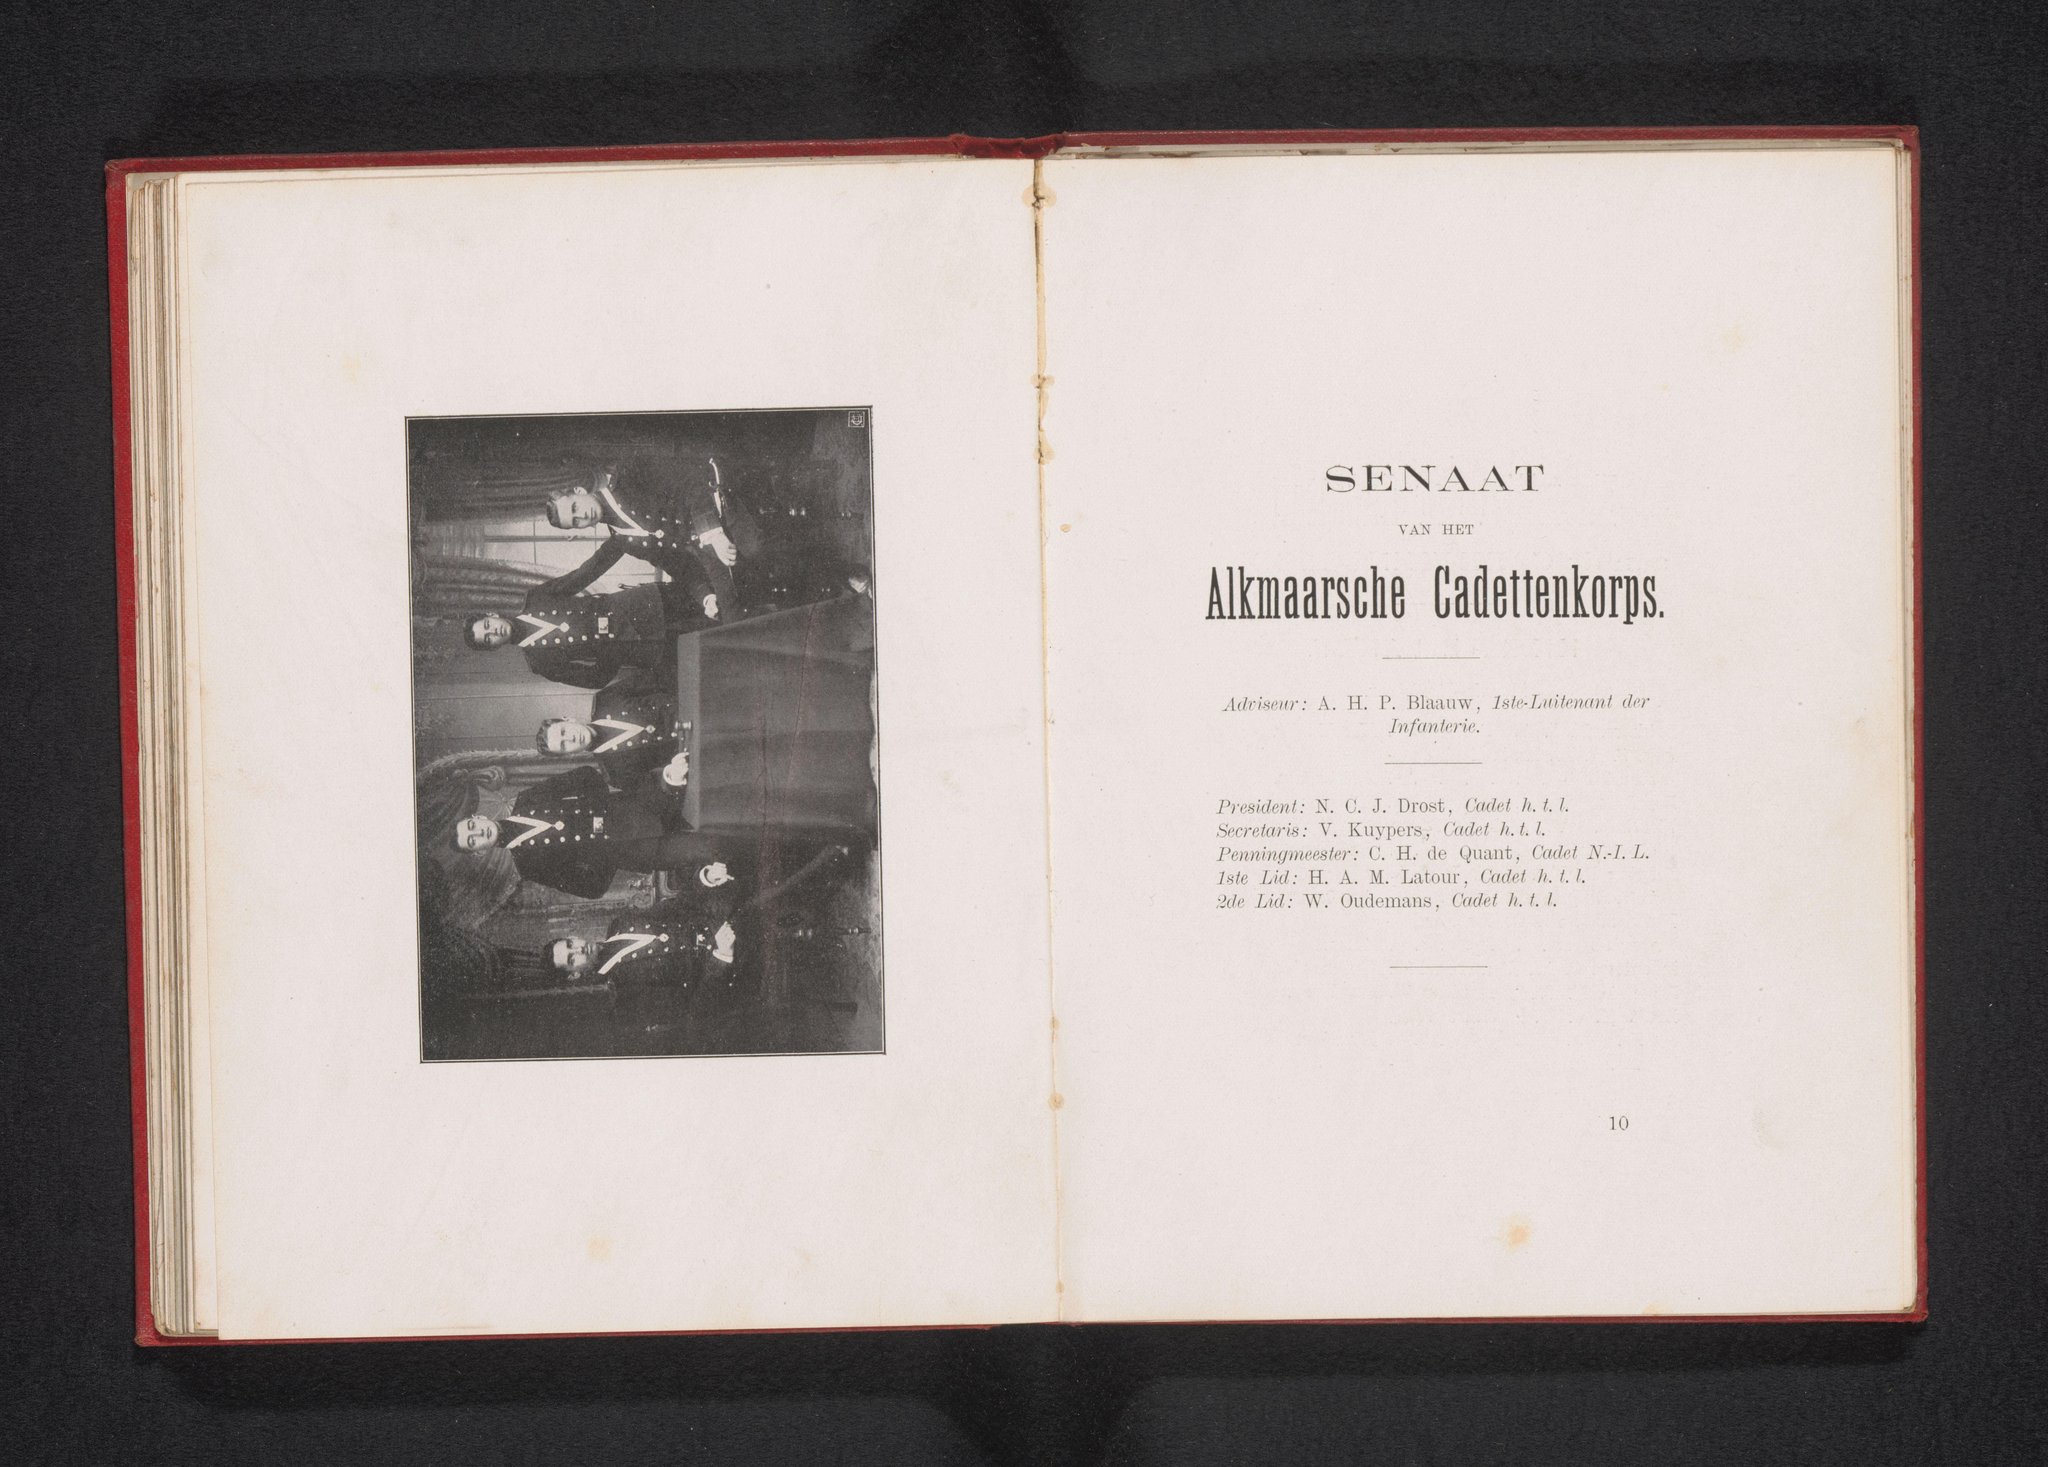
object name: photomechanical print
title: Groepsportret van de Senaat van het Cadettenkorps der Koninklijke Militaire Academie in Breda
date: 1905-1910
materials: paper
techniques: autotype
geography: breda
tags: anonymous historical persons portrayed in a group, in a group-portrait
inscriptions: monogram: ‘CHT’